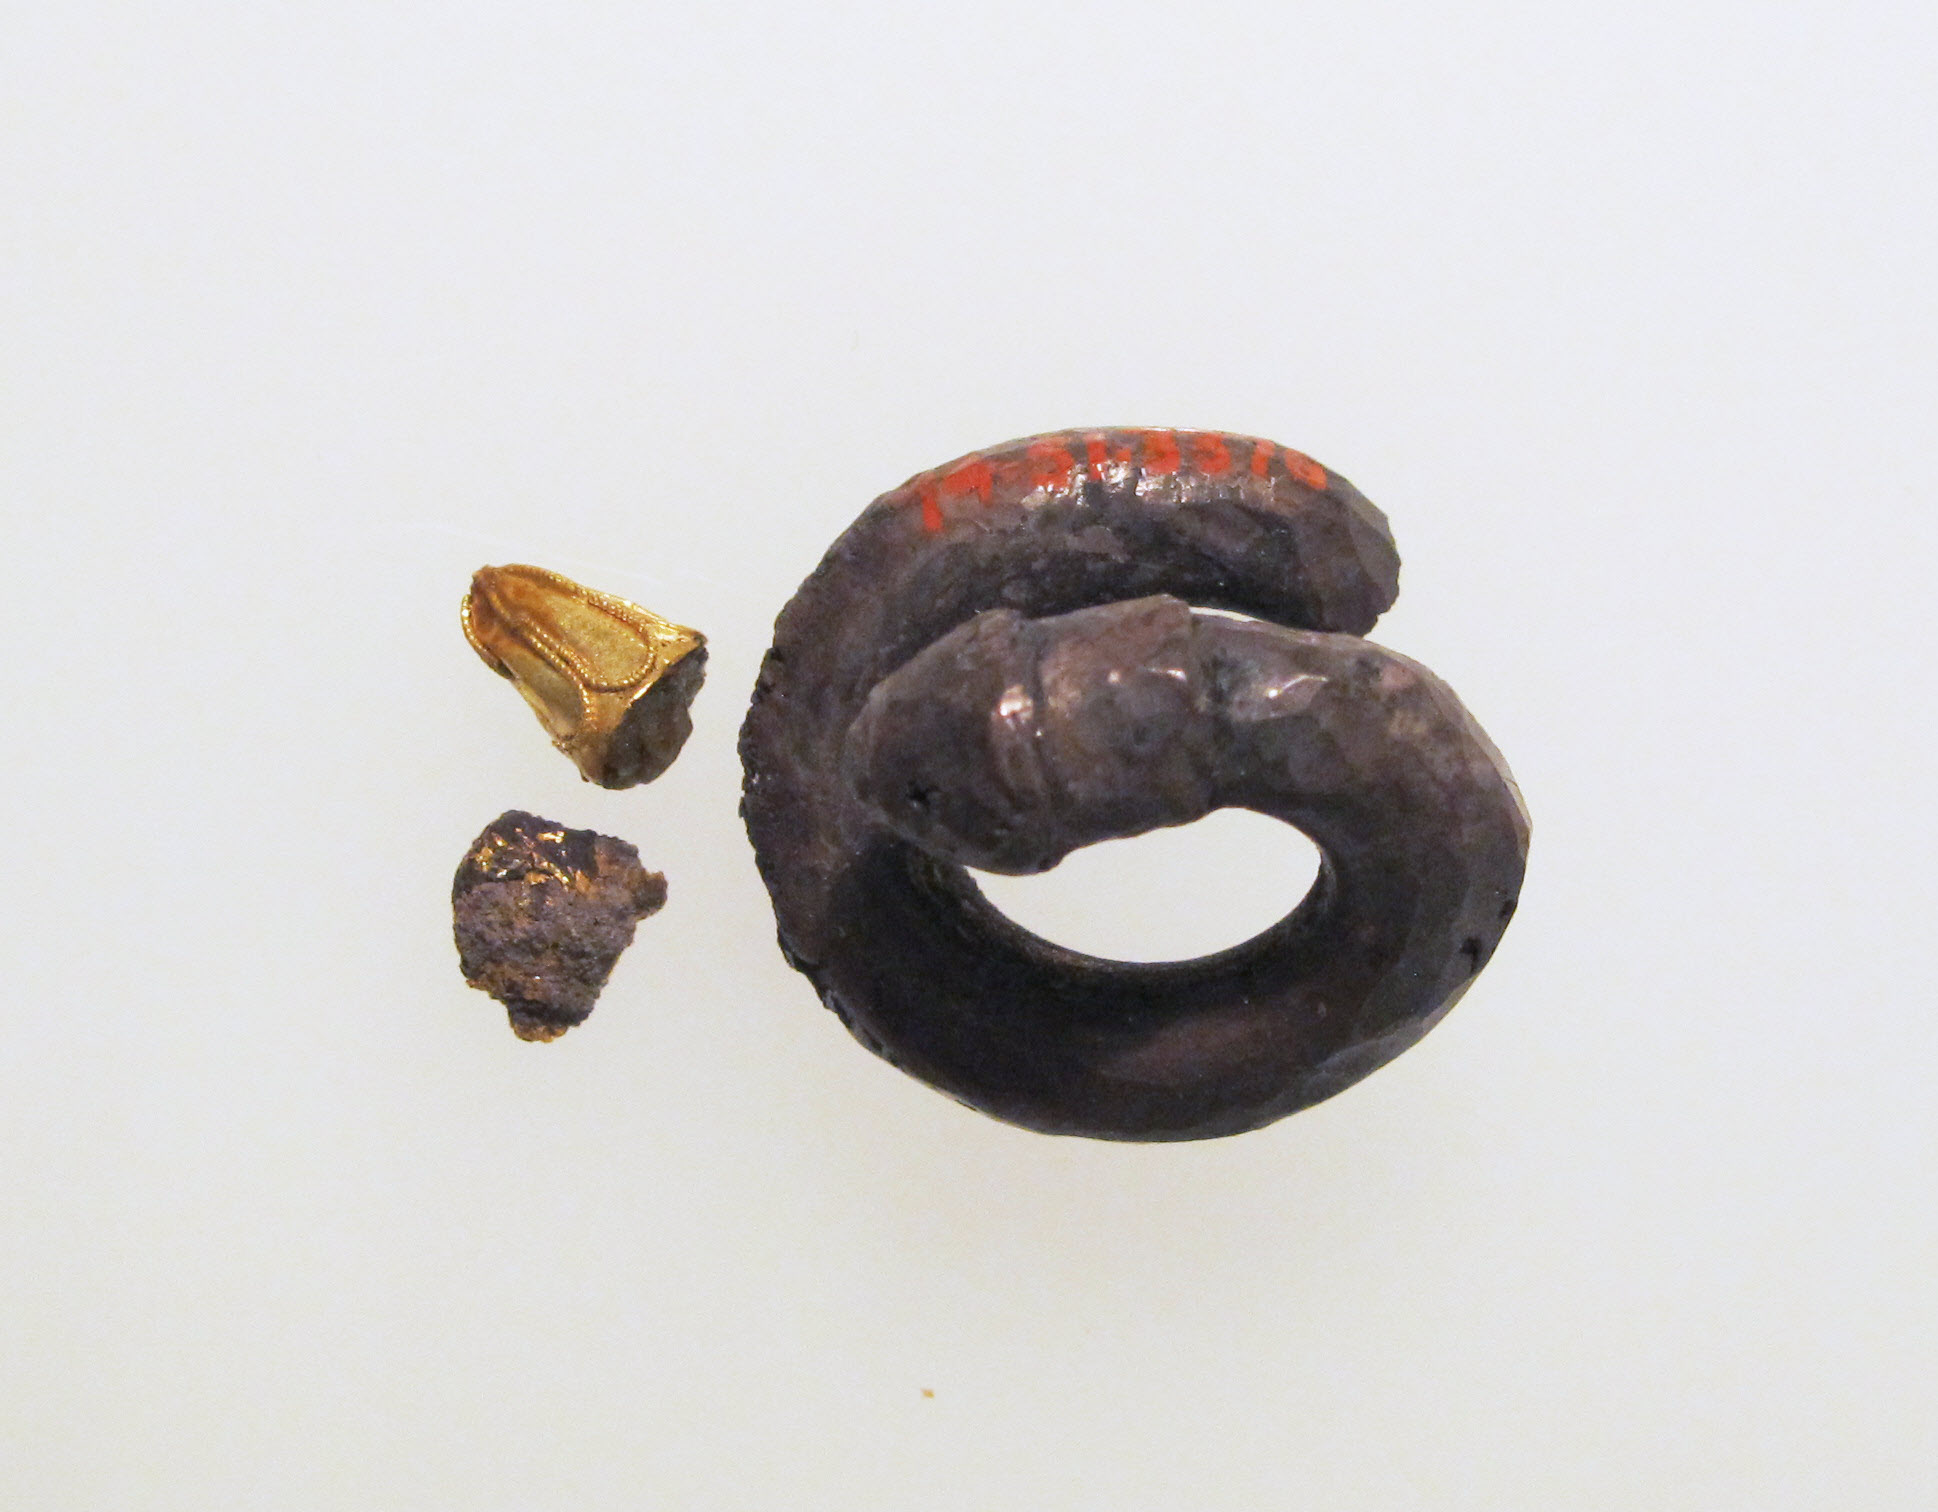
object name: earring, spiral with gold lion head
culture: cypriot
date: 500-401 BCE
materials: gold, silver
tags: lions